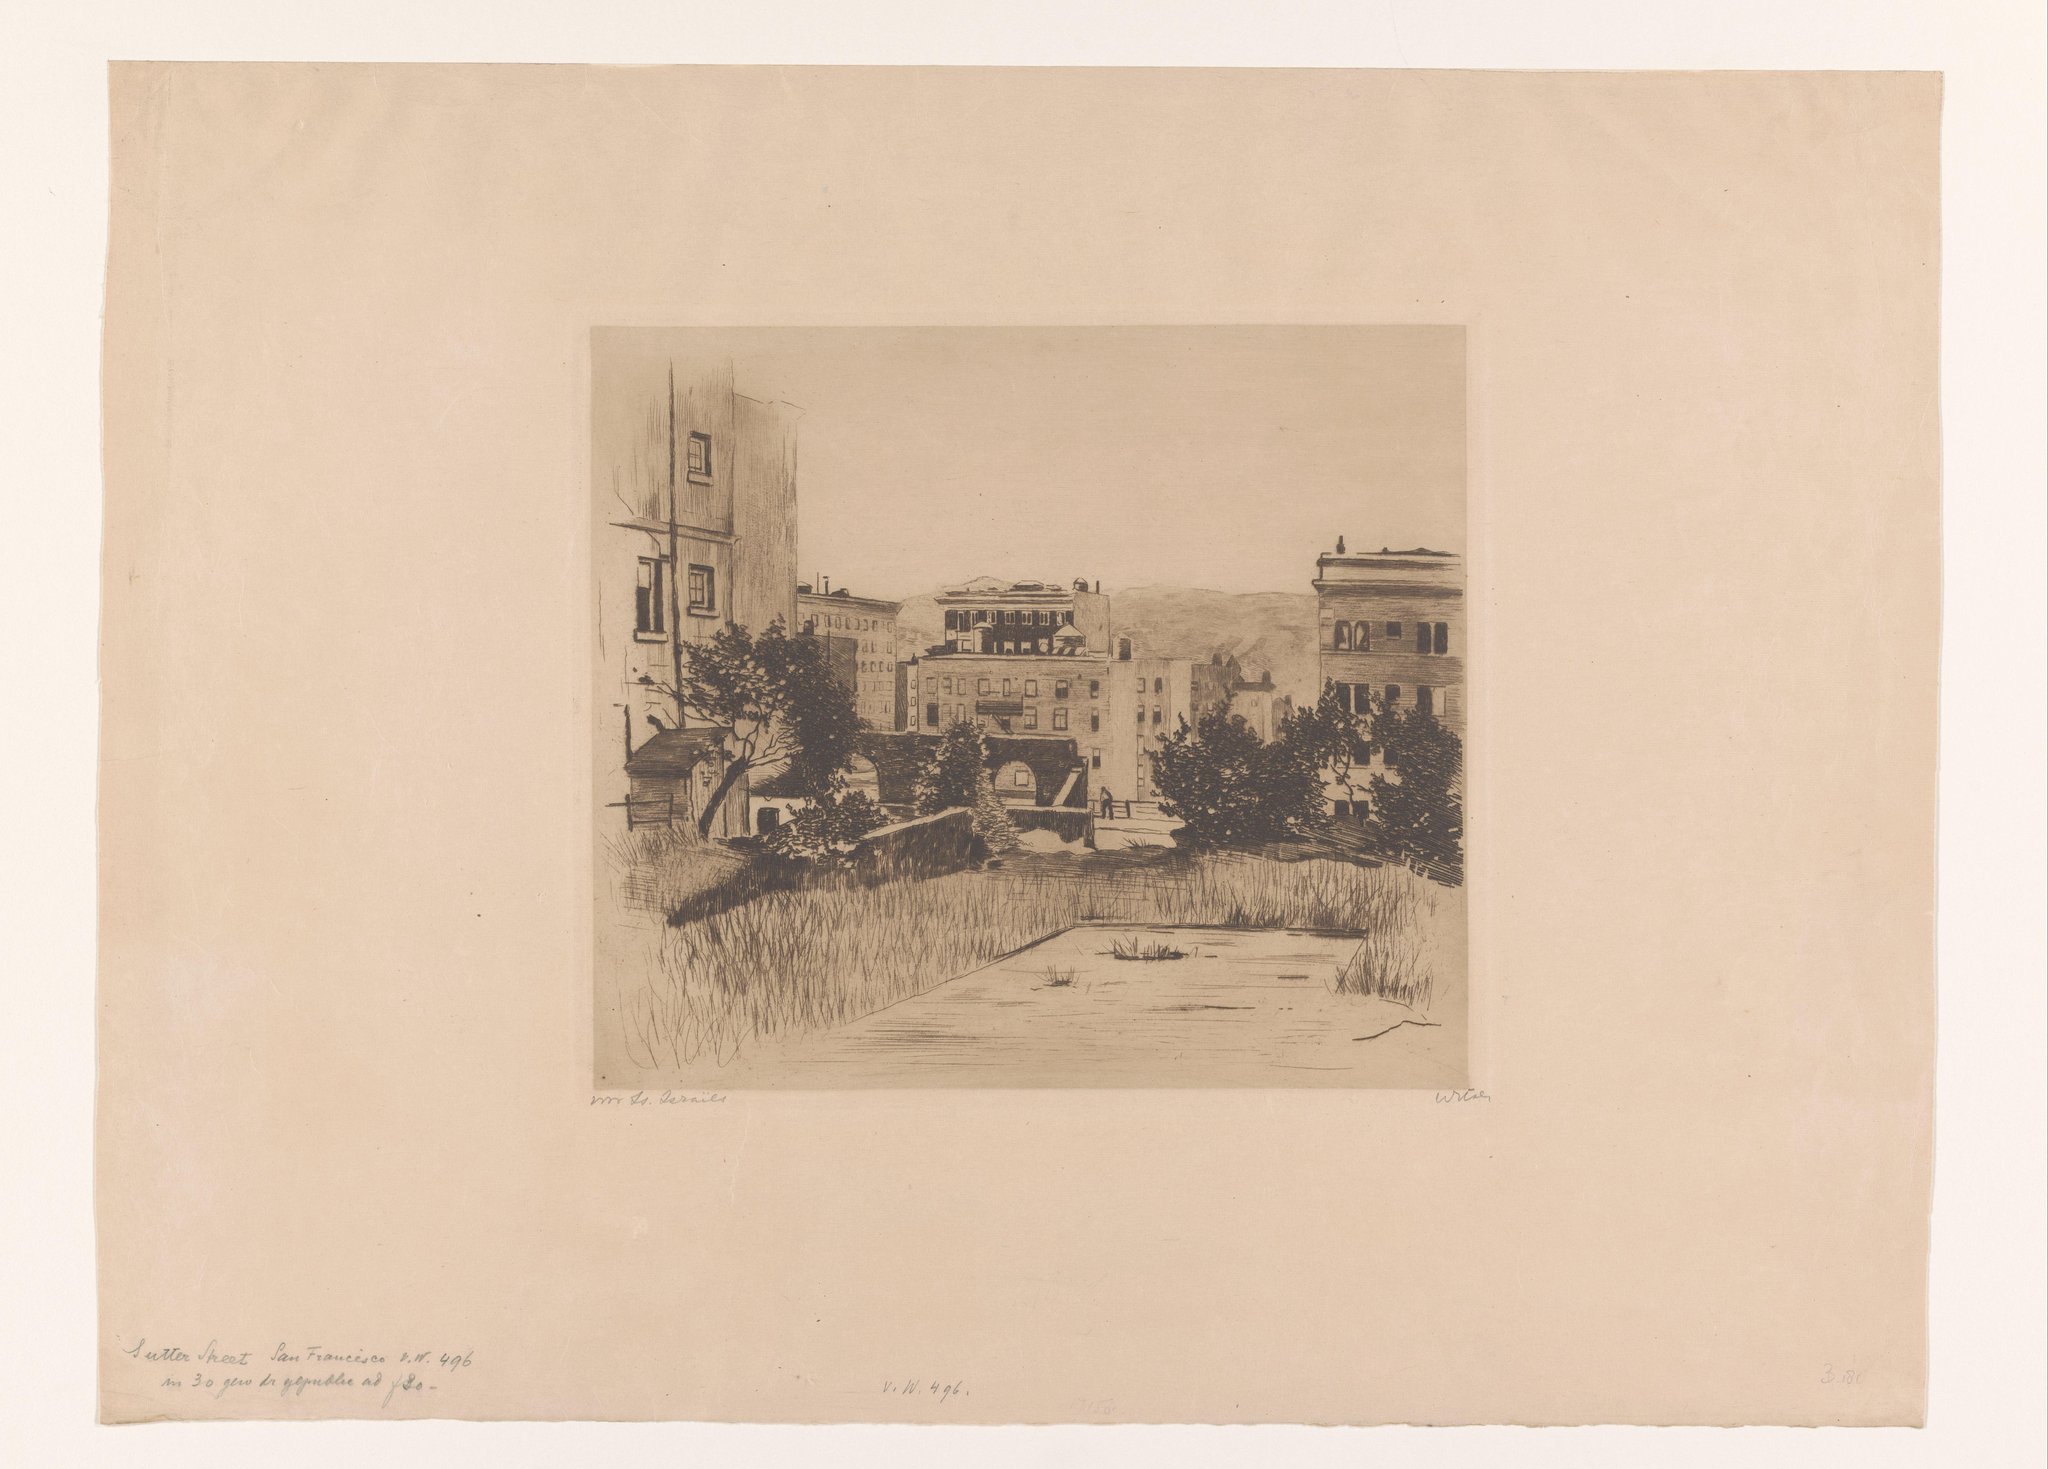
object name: print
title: Sutter Street, San Francisco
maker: willem witsen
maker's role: draughtsman, painter, print maker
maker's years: 1860-1923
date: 1915-1919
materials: paper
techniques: aquatint, etching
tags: city-view in general; 'veduta', street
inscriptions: dedication: ‘voor Is. Israëls’, annotation: ‘Sutter Street San Francisco vW 496./ In 30 gew dr gepublic ad fl. 30,-’, collector's mark: Lugt 2228, collector's mark: Lugt 2760